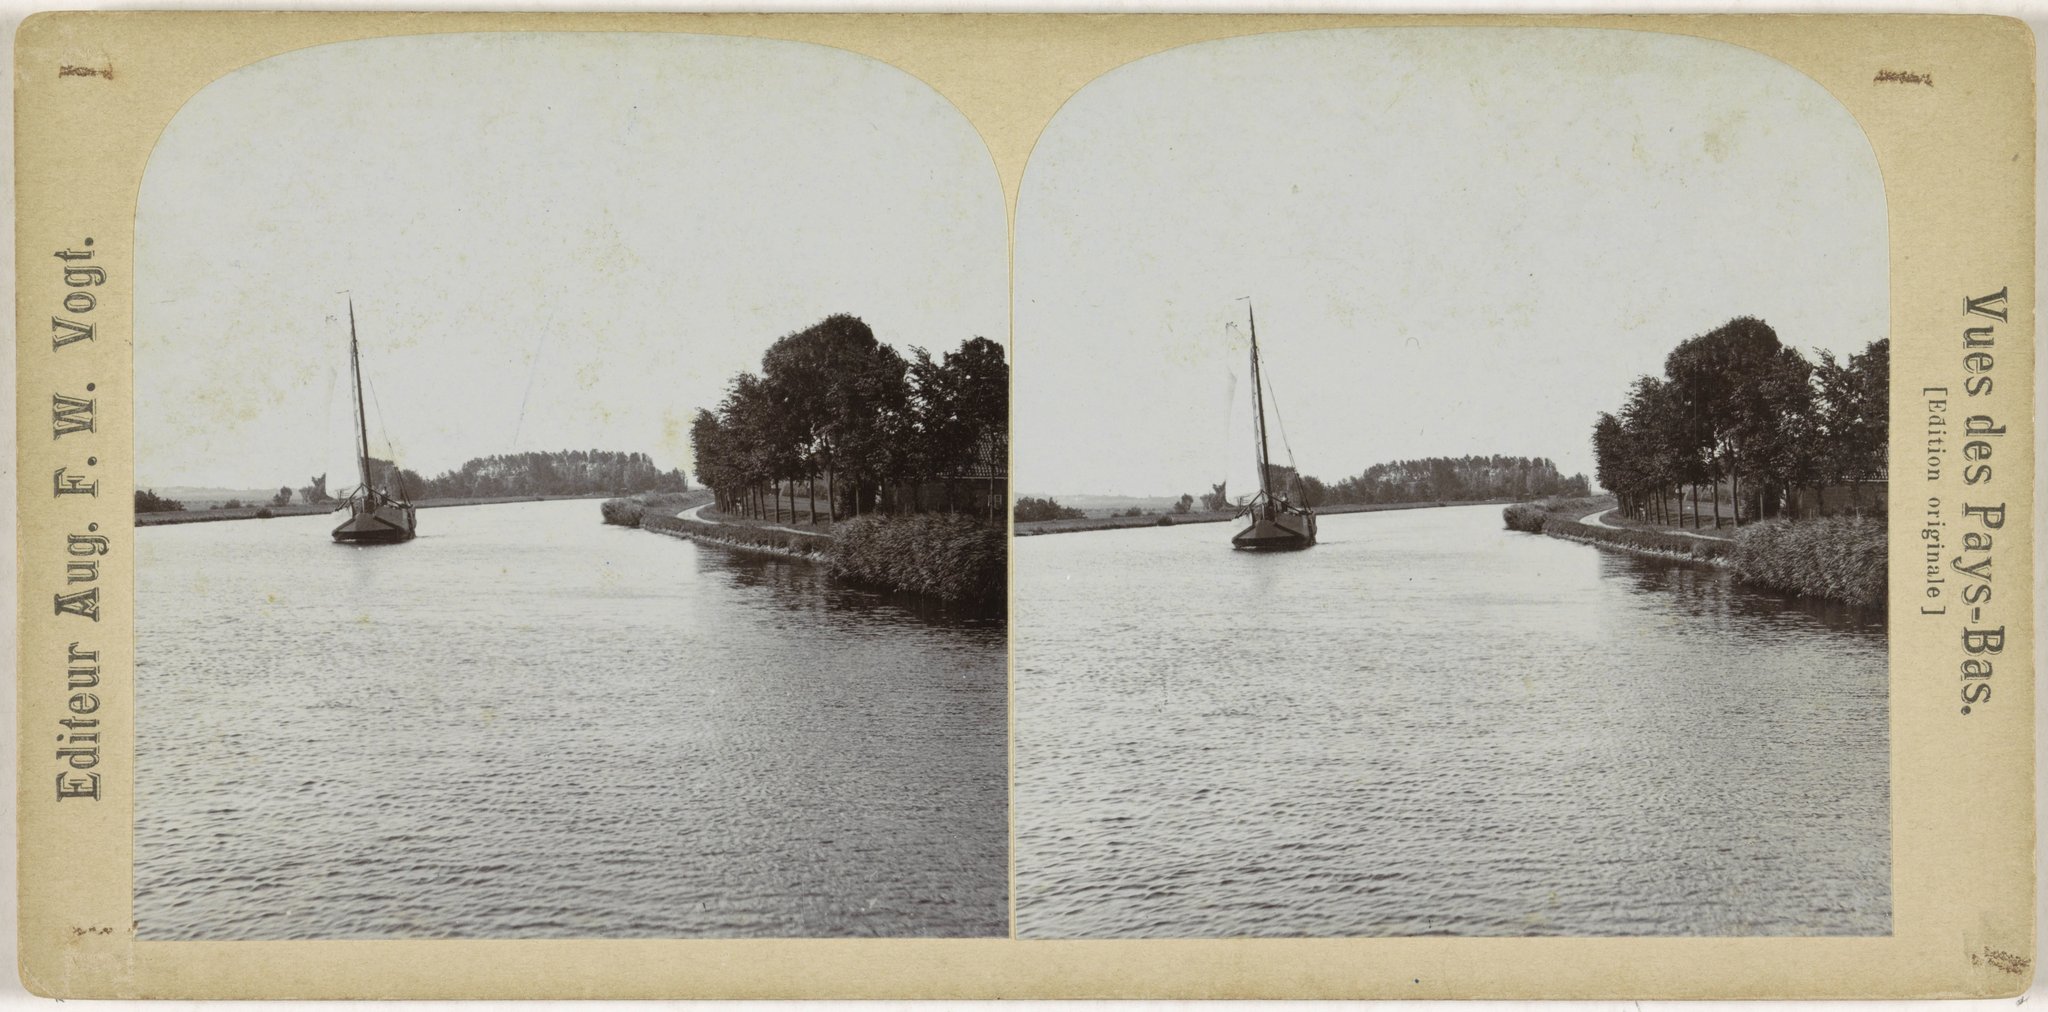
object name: stereograph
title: Gezicht op de Schinkel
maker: august frederik willem vogt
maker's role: fotograaf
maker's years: 1871-1922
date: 1870-1920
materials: cardboard, paper, photographic support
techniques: gelatin silver print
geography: new york city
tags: amsterdam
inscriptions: number: ‘Langs de Schinkel’, inscription: ‘Vues des Pays-Bas. [Edition originale]’